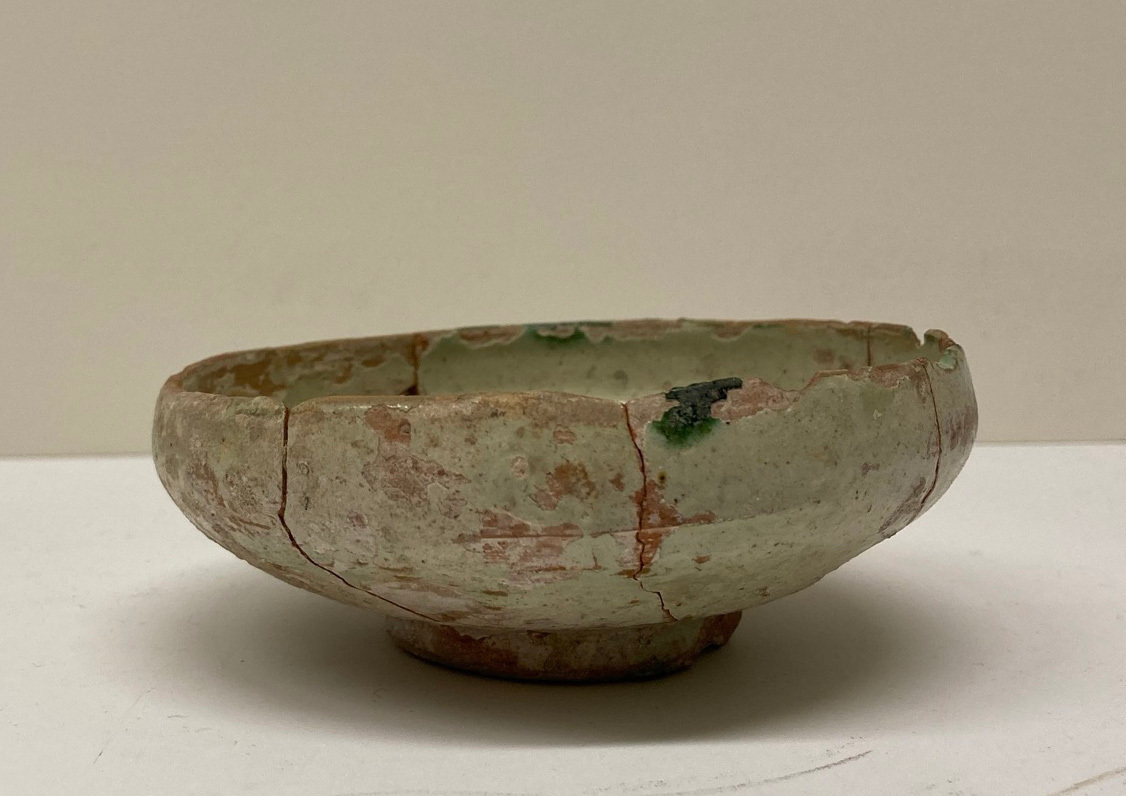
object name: bowl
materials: earthenware, glaze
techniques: polychrome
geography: iran